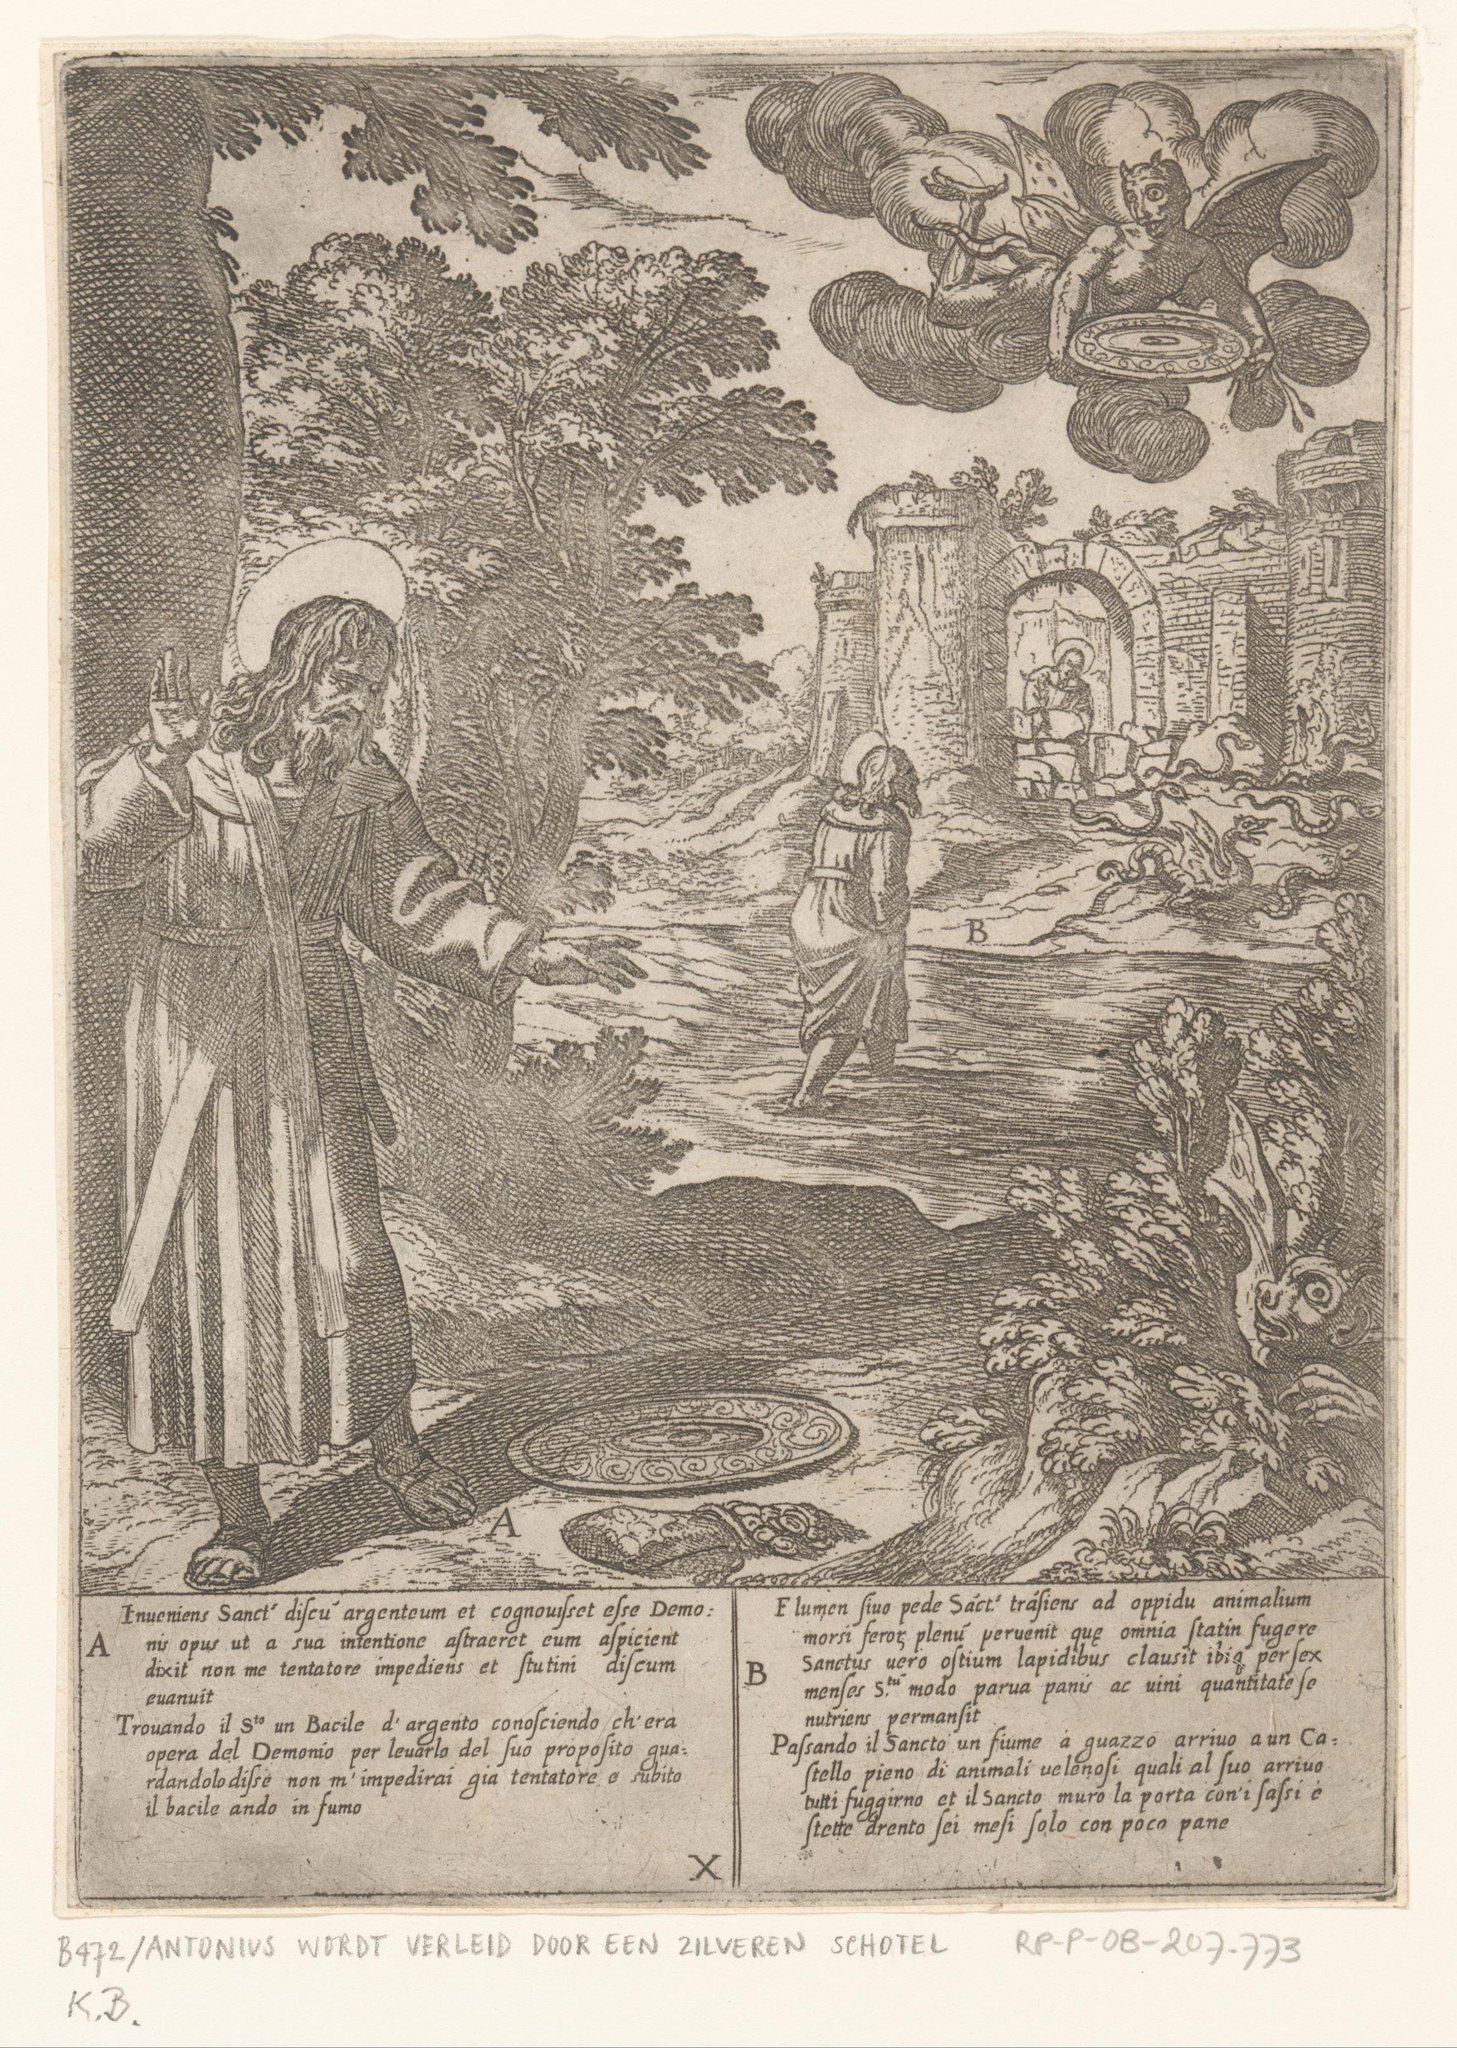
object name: print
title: H. Antonius in verleiding gebracht door een zilveren schotel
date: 1598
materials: paper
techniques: etching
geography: rome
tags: temptations of st. antony abbot, the hermit antony abbot (antonius abbas) of egypt, also called the great; possible attributes: bell, book, t-shaped staff, flames, pig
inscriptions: collector's mark: Lugt 240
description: H. Antonius wordt in verleiding gebracht door een zilveren schotel die op de grond is gelegd door een duivel die zich tussen de struiken heeft verstopt. Op de achtergrond Antonius bij een poort met slangen en draken. Italiaanse en Latijnse tekst in twee kolommen in de ondermarge.